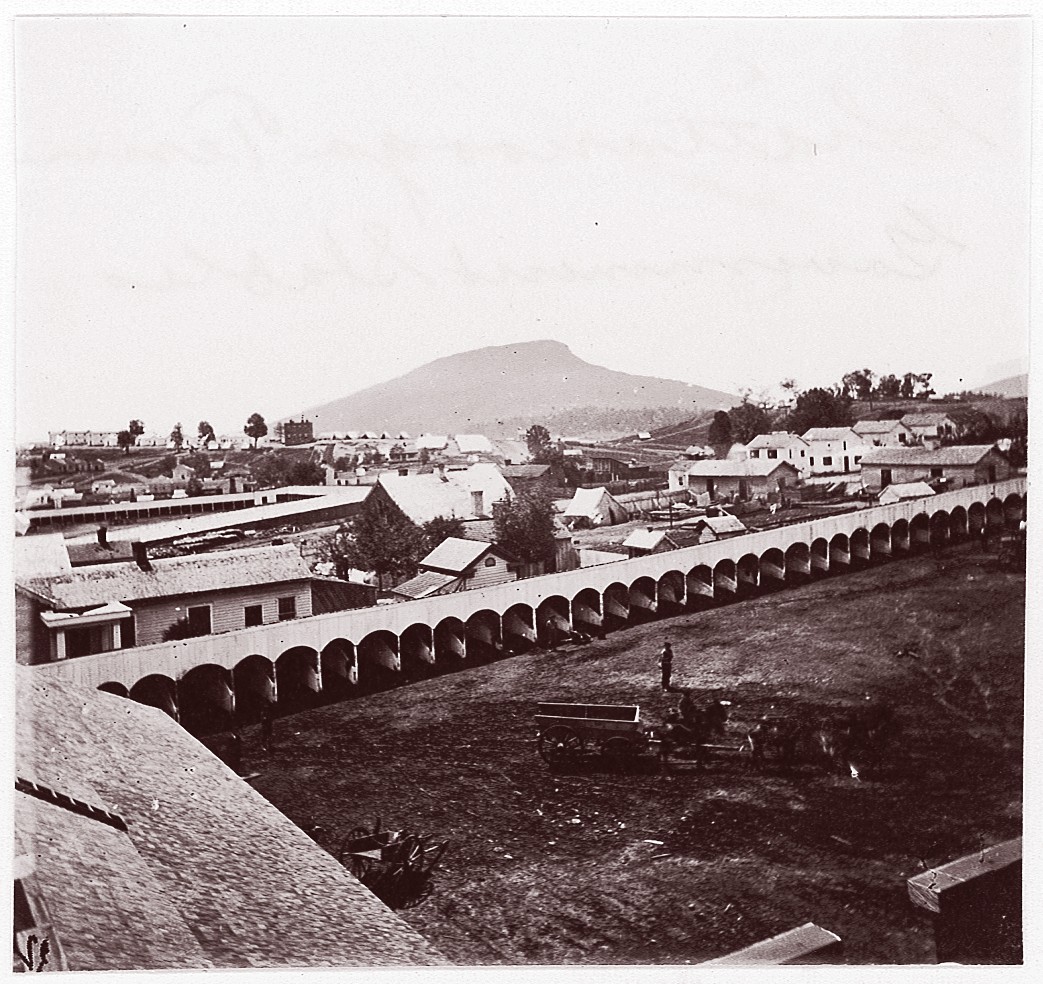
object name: photograph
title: Chattanooga, Tennessee. Government Stable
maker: george n. barnard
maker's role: artist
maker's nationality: american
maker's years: 1819-1902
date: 1864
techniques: albumen silver print, glass negative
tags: buildings,american civil war